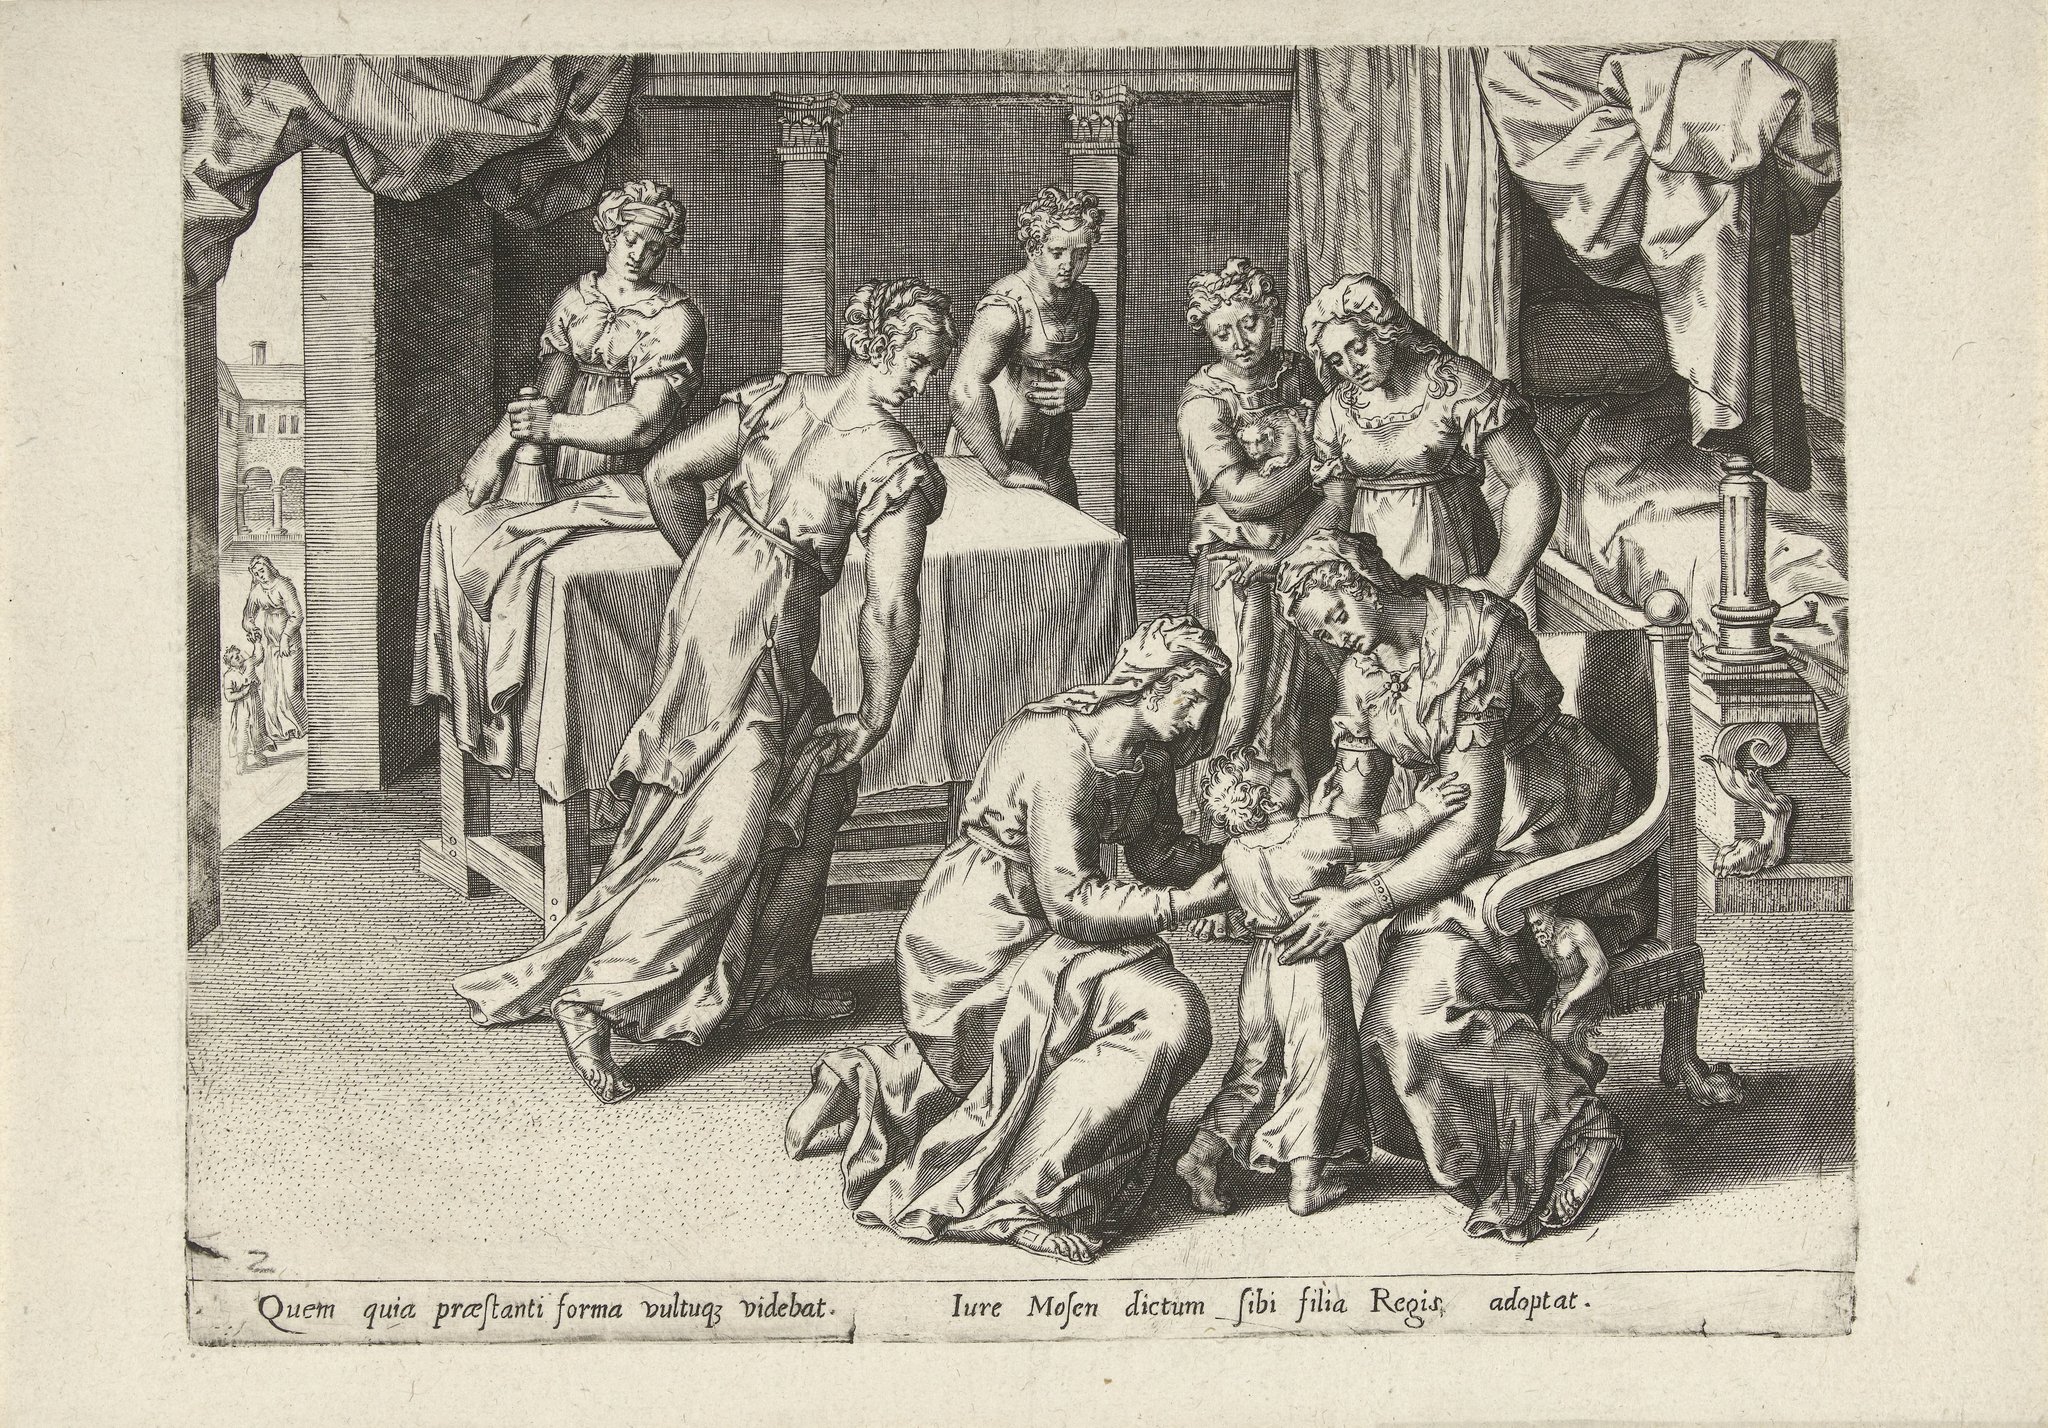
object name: print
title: Mozes wordt geadopteerd door de dochter van de farao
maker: pieter jalhea furnius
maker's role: print maker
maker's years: 1540-1626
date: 1550-1625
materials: paper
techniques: engraving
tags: when moses is old enough, his mother brings him to pharaoh's daughter, who adopts him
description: De dochter van de farao zit op een stoel en tilt de kleine Mozes van de grond. Mozes' moeder zit er geknield naast, op de achtergrond zijn dienstmaagden in de weer. Onder de voorstelling staat een regel tekst in het Latijn.